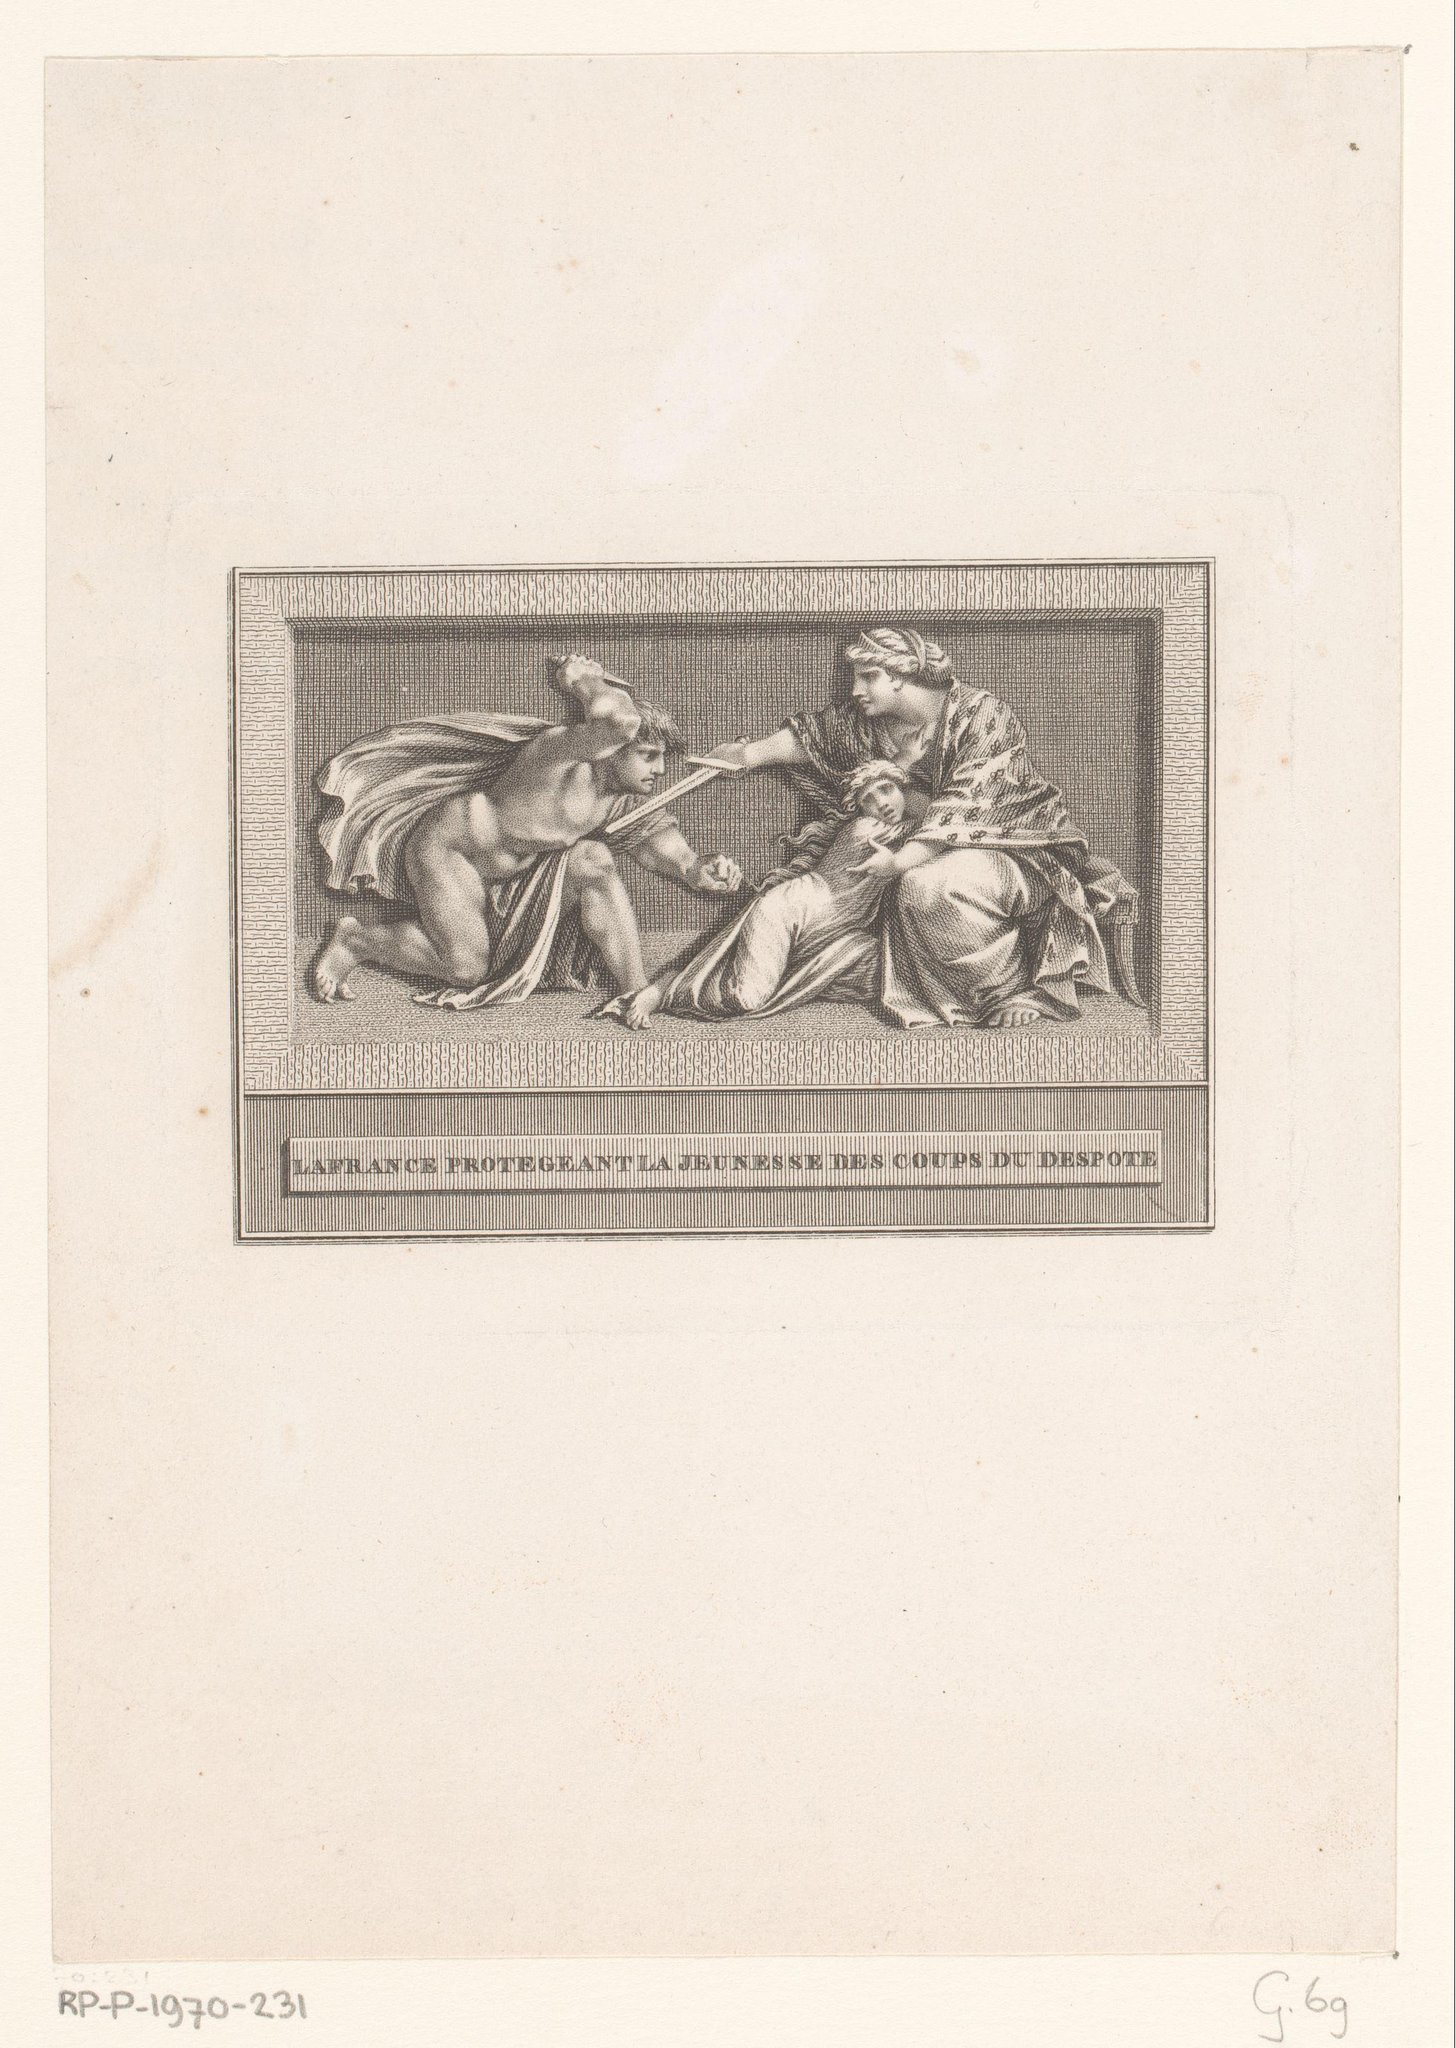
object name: print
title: La France protegeant la jeunesse des coups du despote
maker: Anonymous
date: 1789-1804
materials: paper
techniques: engraving, etching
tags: napoleon i (emperor of the french), personification of a city, town-patron(ess), historical persons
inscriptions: collector's mark: Lugt 2228, collector's mark: Lugt 2760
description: Bewerking van de prent 'La Loi' met Napoleon als aanvaller.